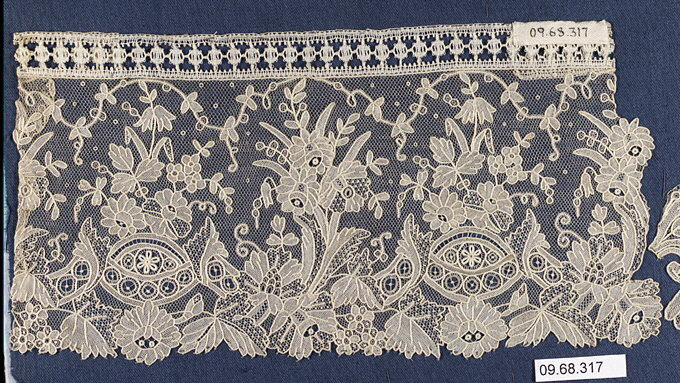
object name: specimen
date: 1801-1900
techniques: lace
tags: flowers